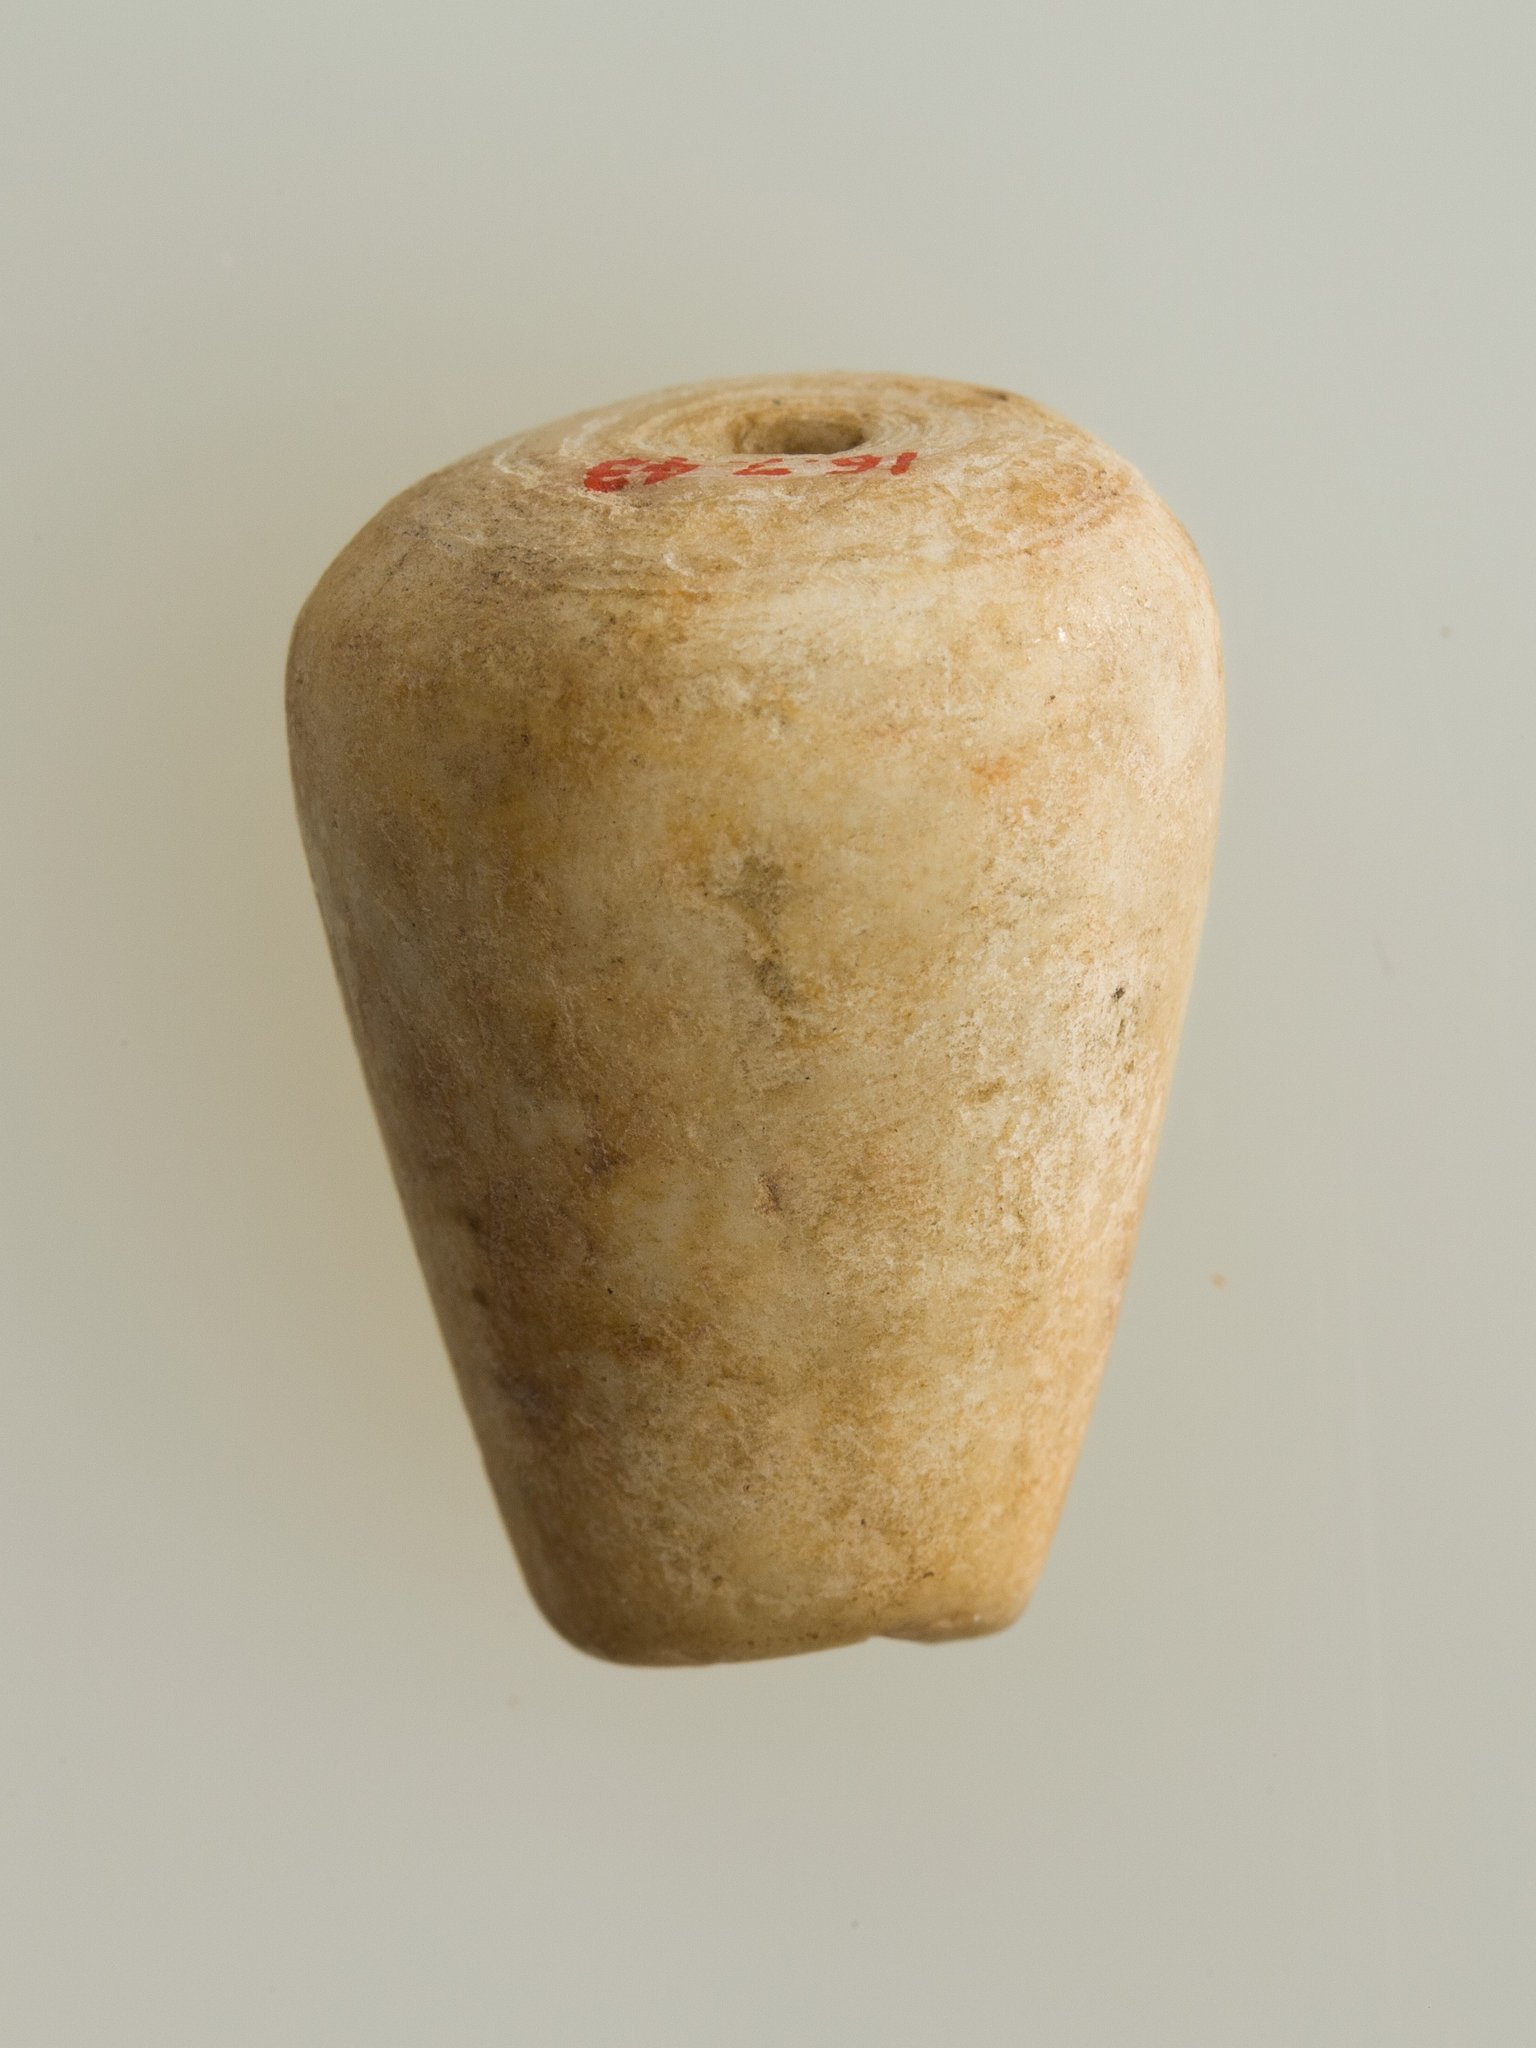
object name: pendant, shell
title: Shell pendant or bead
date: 3850-2960 BCE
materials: shell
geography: egypt